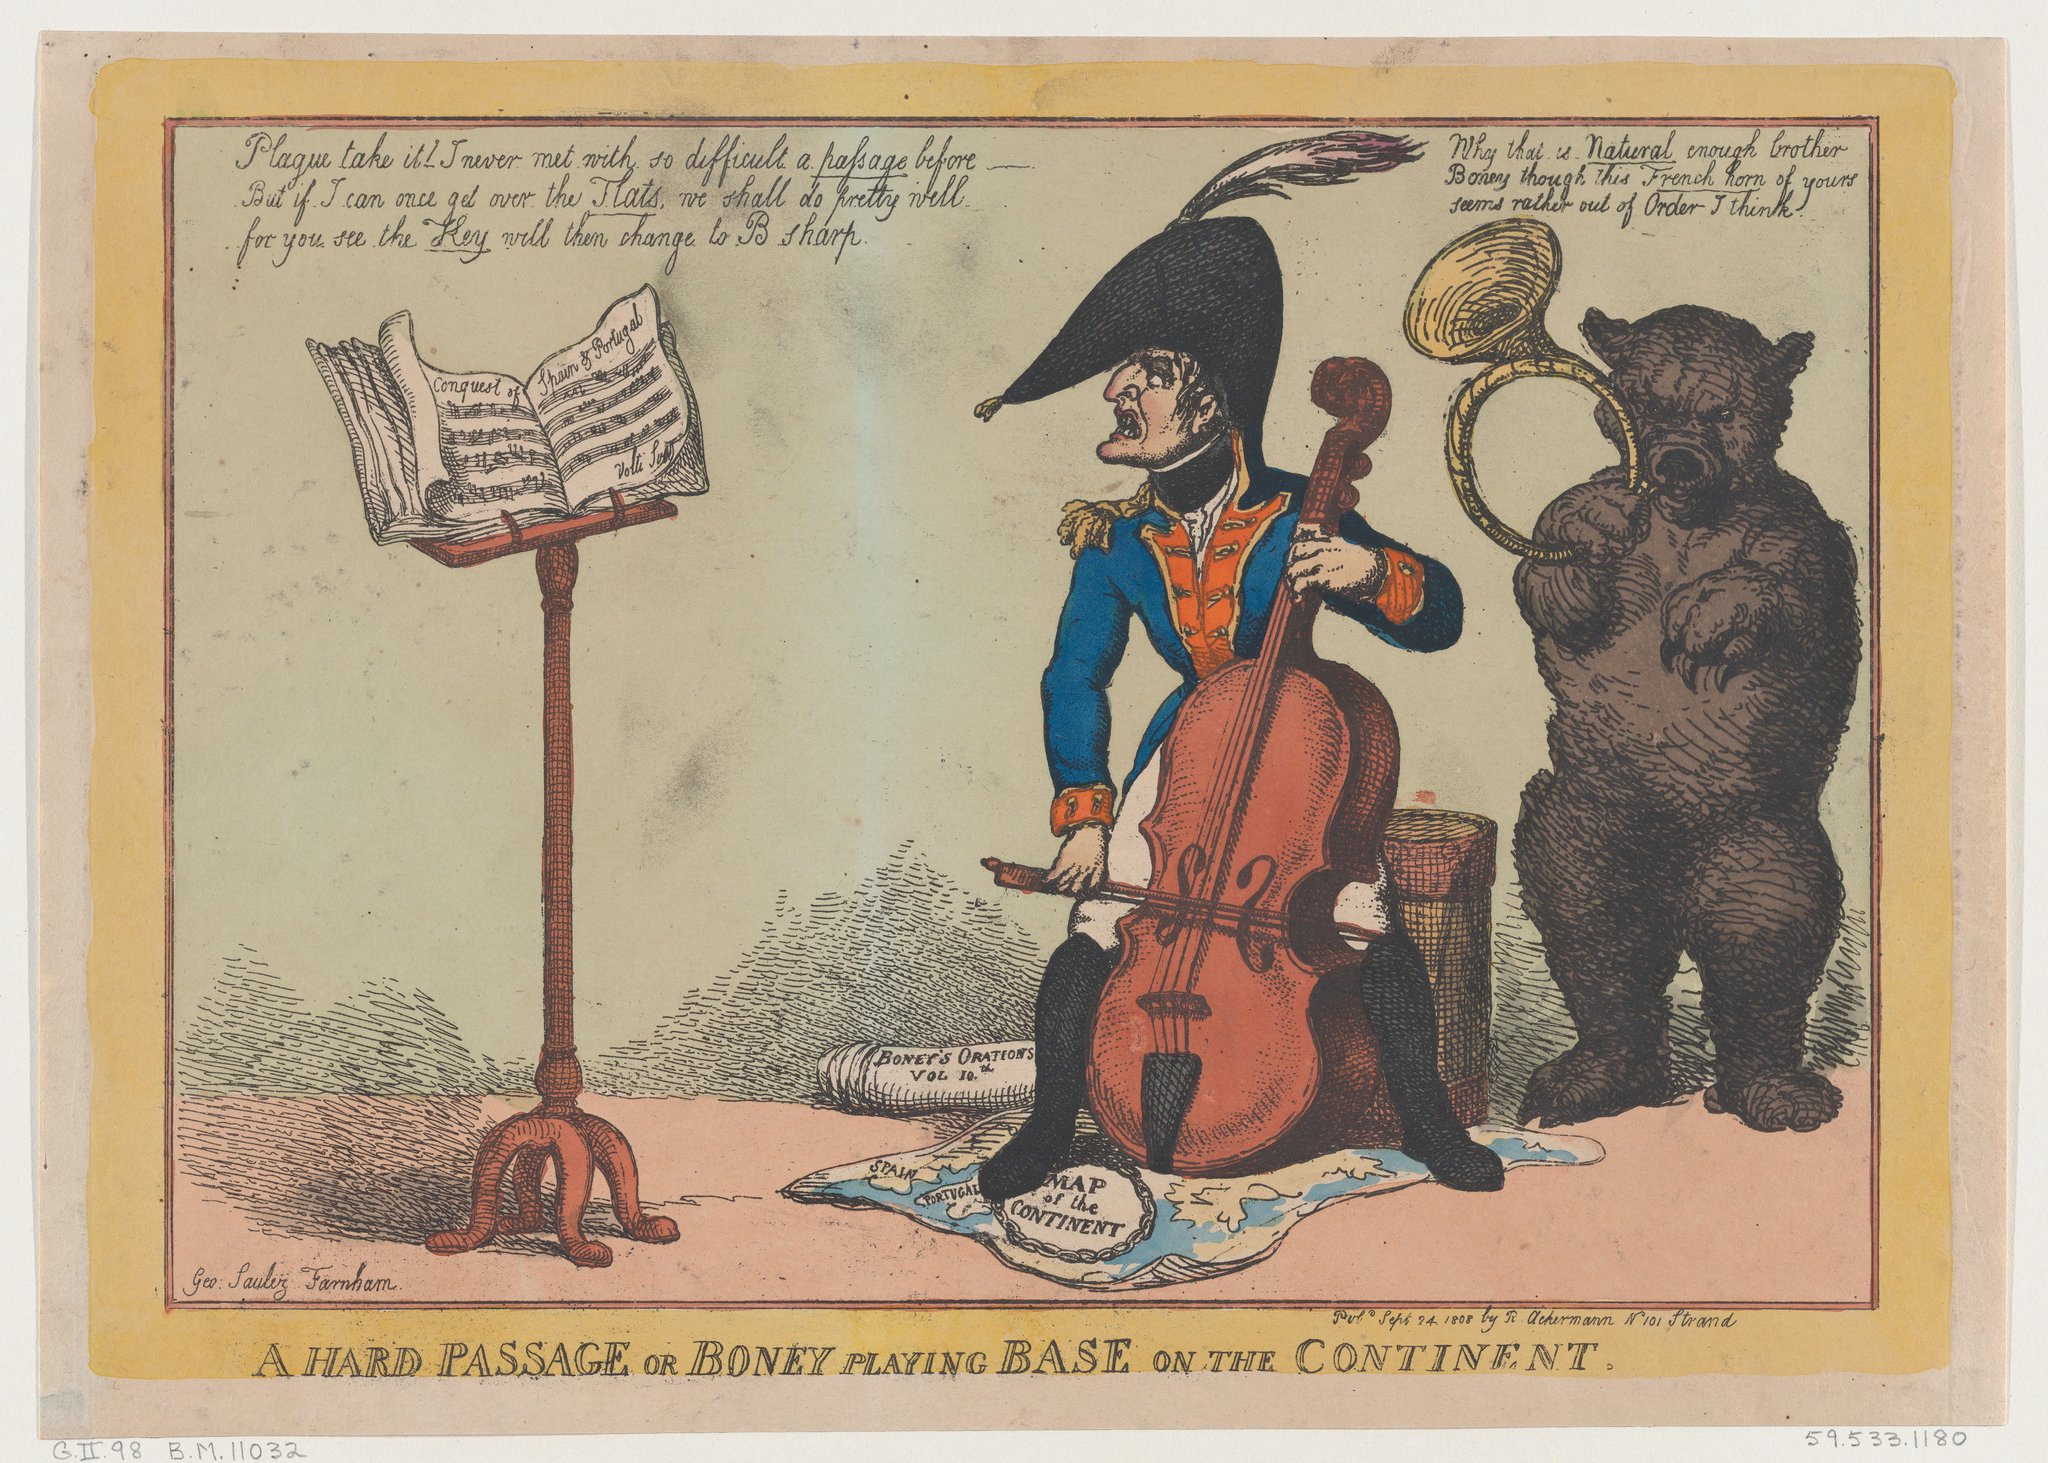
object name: print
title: A Hard Passage, or Boney Playing Base on the Continent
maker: thomas rowlandson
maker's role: artist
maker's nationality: british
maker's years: 1757-1827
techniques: etching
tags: musical instruments,bears,satire,napoleon i,men,politics